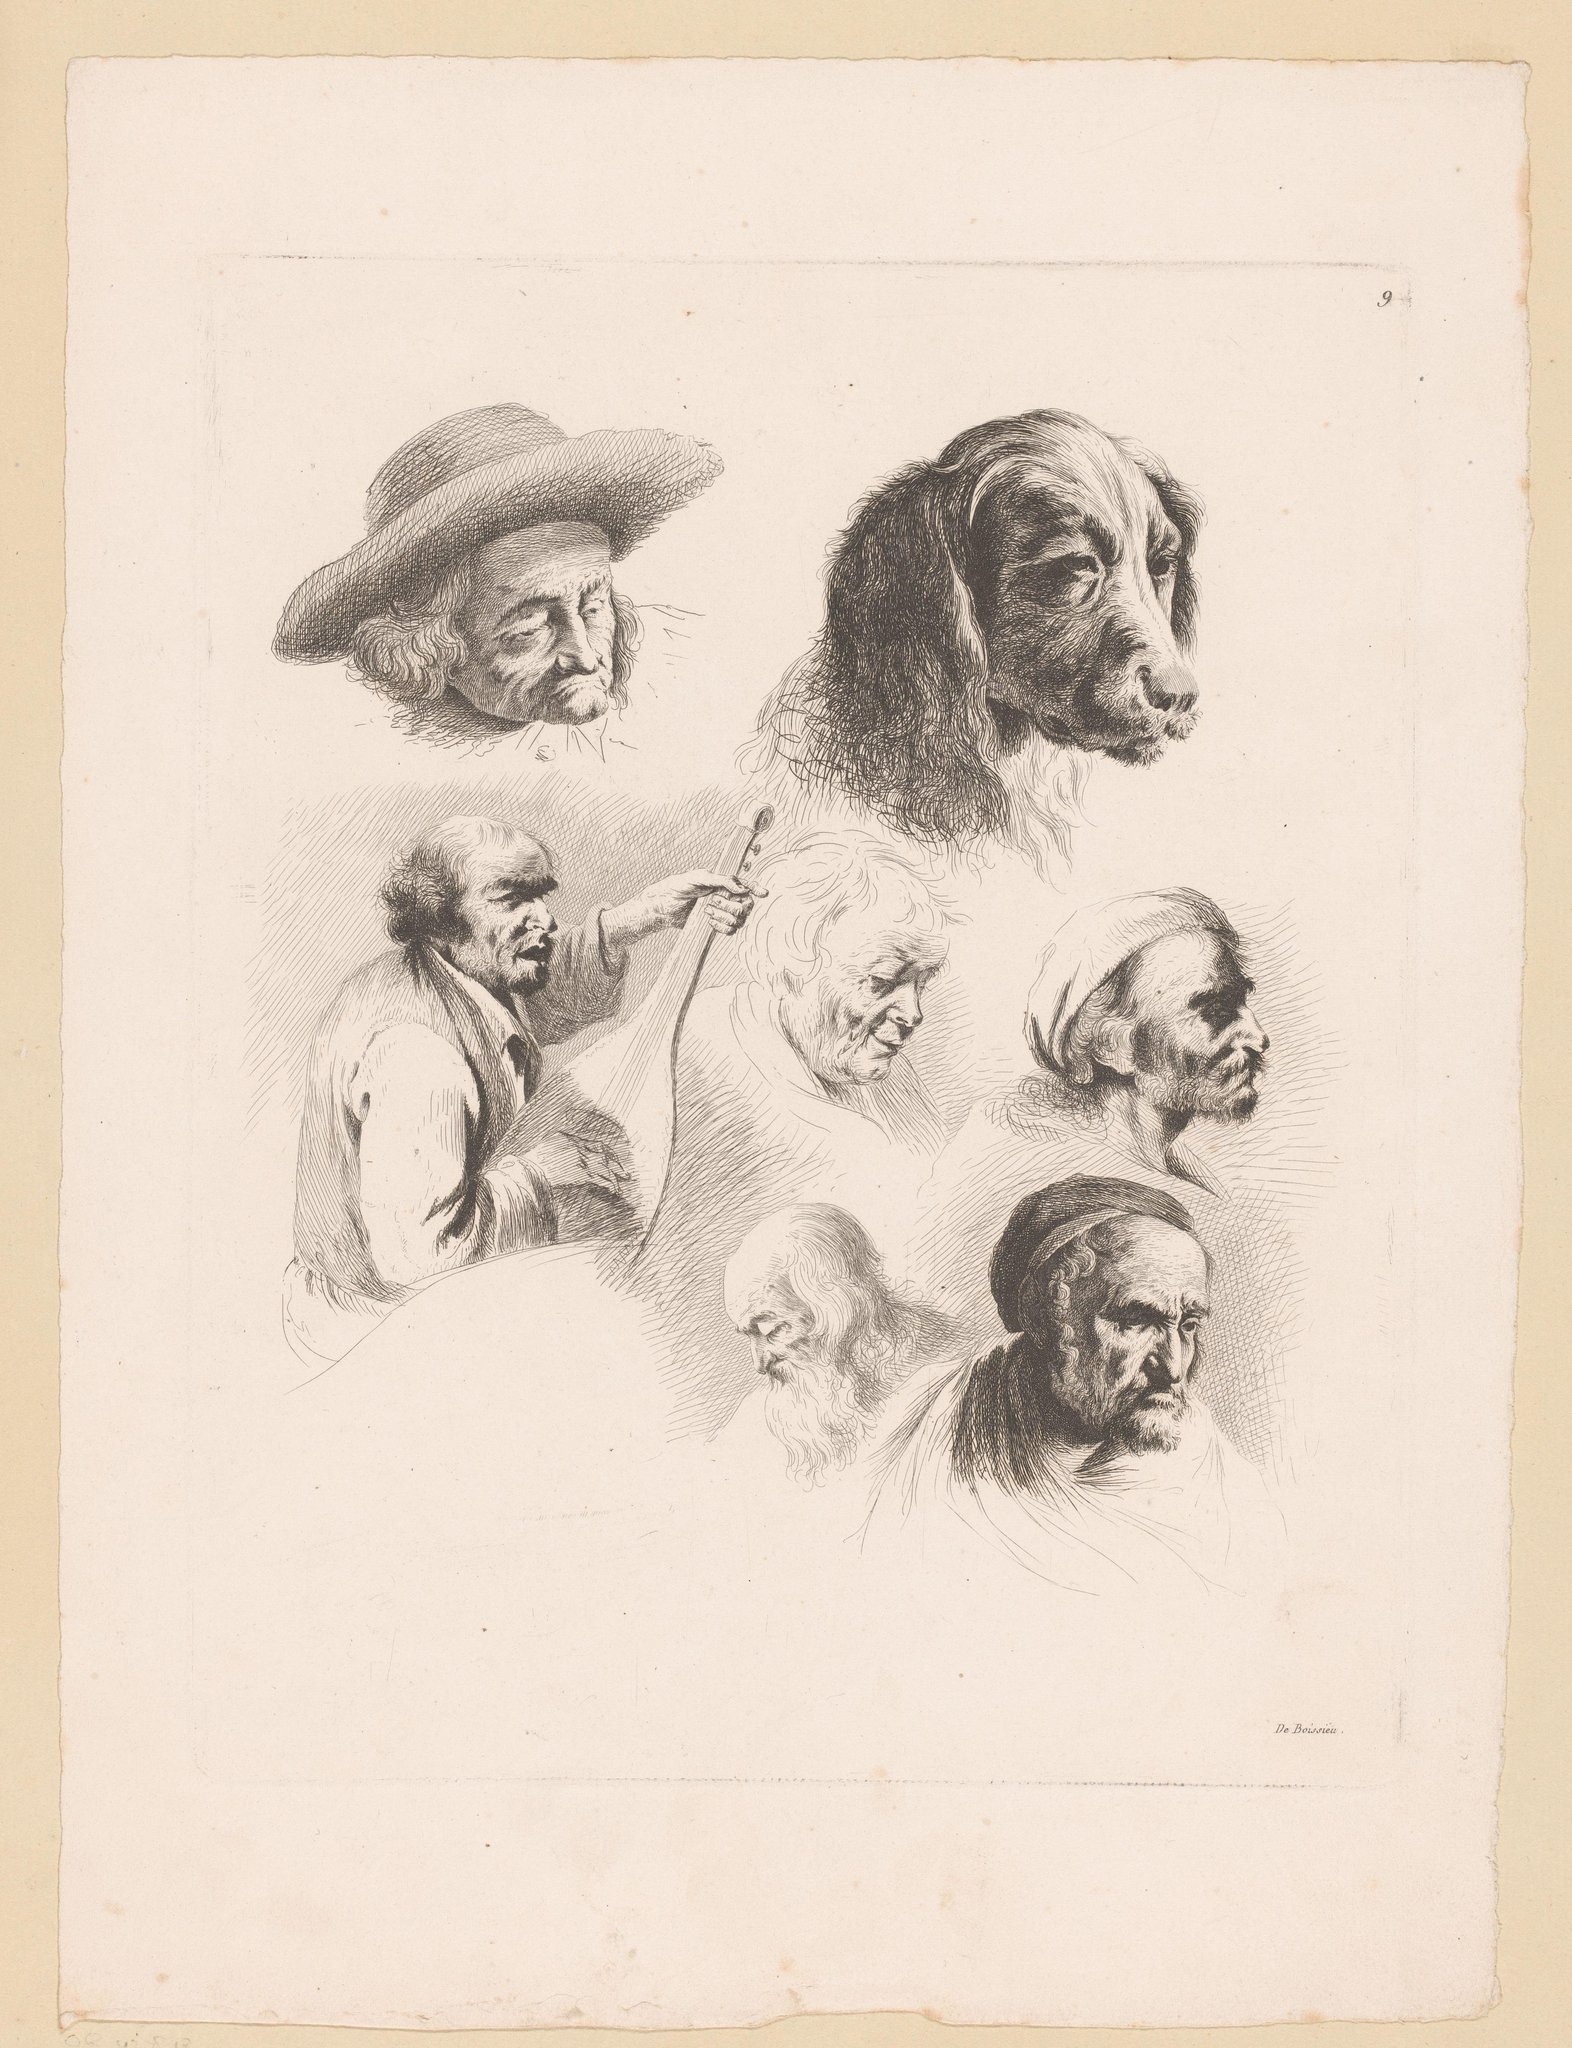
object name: print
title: Compositie met zes hoofden van verschillende mannen en de kop van een hond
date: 1805-1844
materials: paper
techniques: engraving, etching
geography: france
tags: head-gear, old man, lute, and special forms of lute, e.g.: theorbo